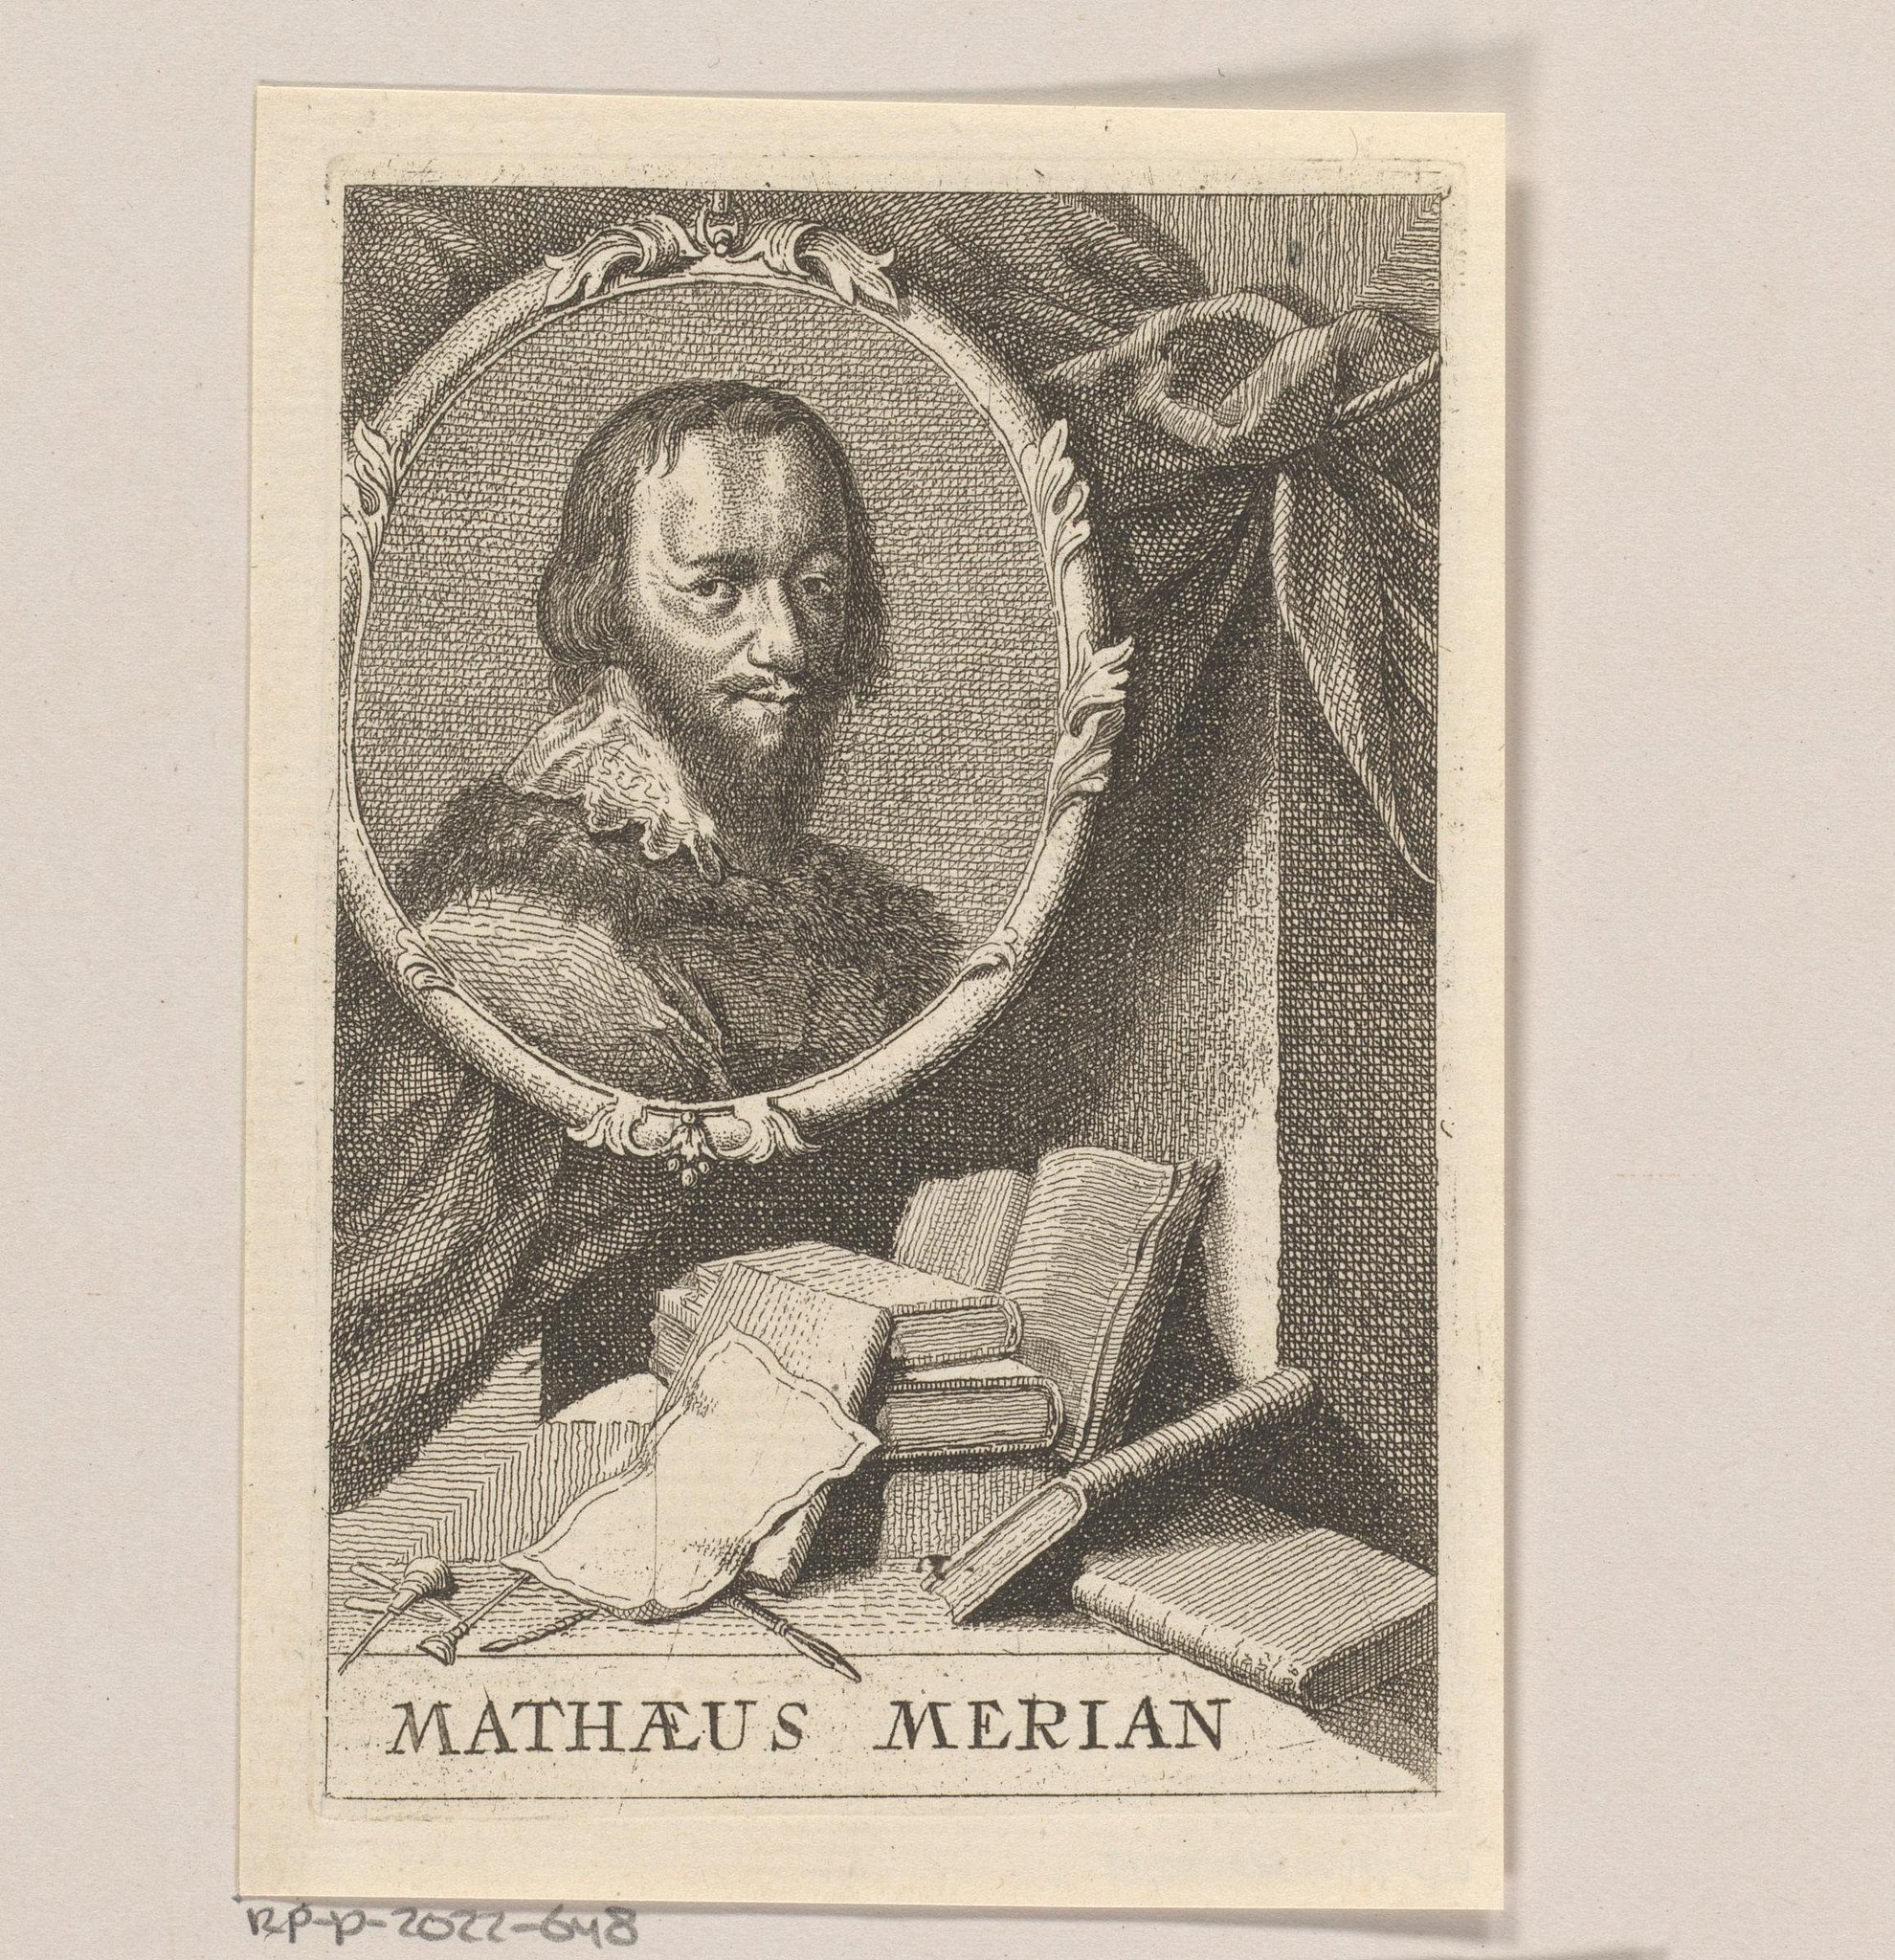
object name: book illustration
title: Portret van Matthäus Merian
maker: Anonymous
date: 1755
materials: paper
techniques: etching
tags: print maker, historical persons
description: Prent waarschijnlijk uit: Füssli, Johann Kaspar. Geschichte Und Abbildung der besten Mahler in der Schweitz. Zürich: David Gessner, 1755, dl. 1.